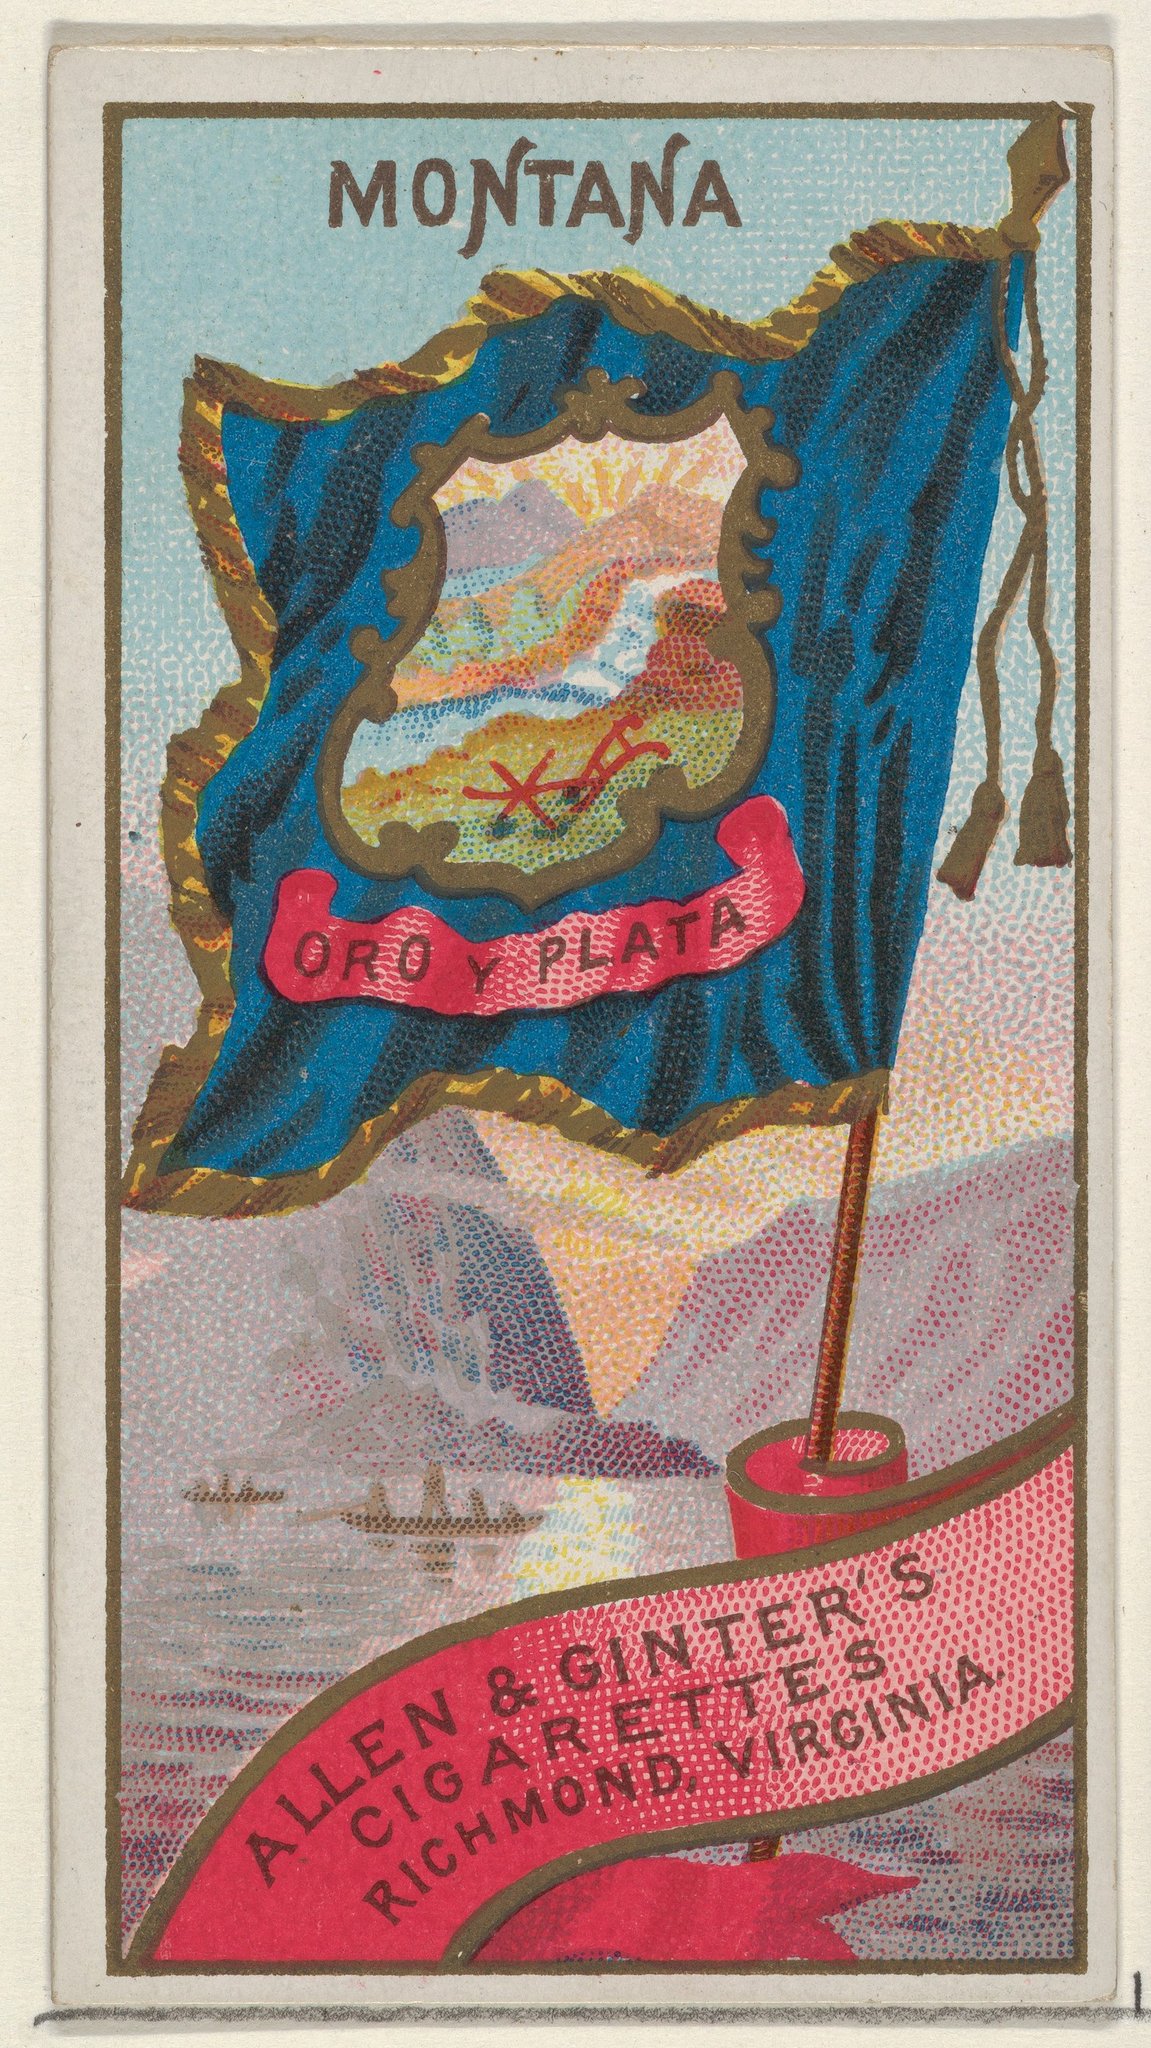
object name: print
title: Montana, from Flags of the States and Territories (N11) for Allen & Ginter Cigarettes Brands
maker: allen & ginter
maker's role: publisher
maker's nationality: american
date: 1888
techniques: color lithograph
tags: flags